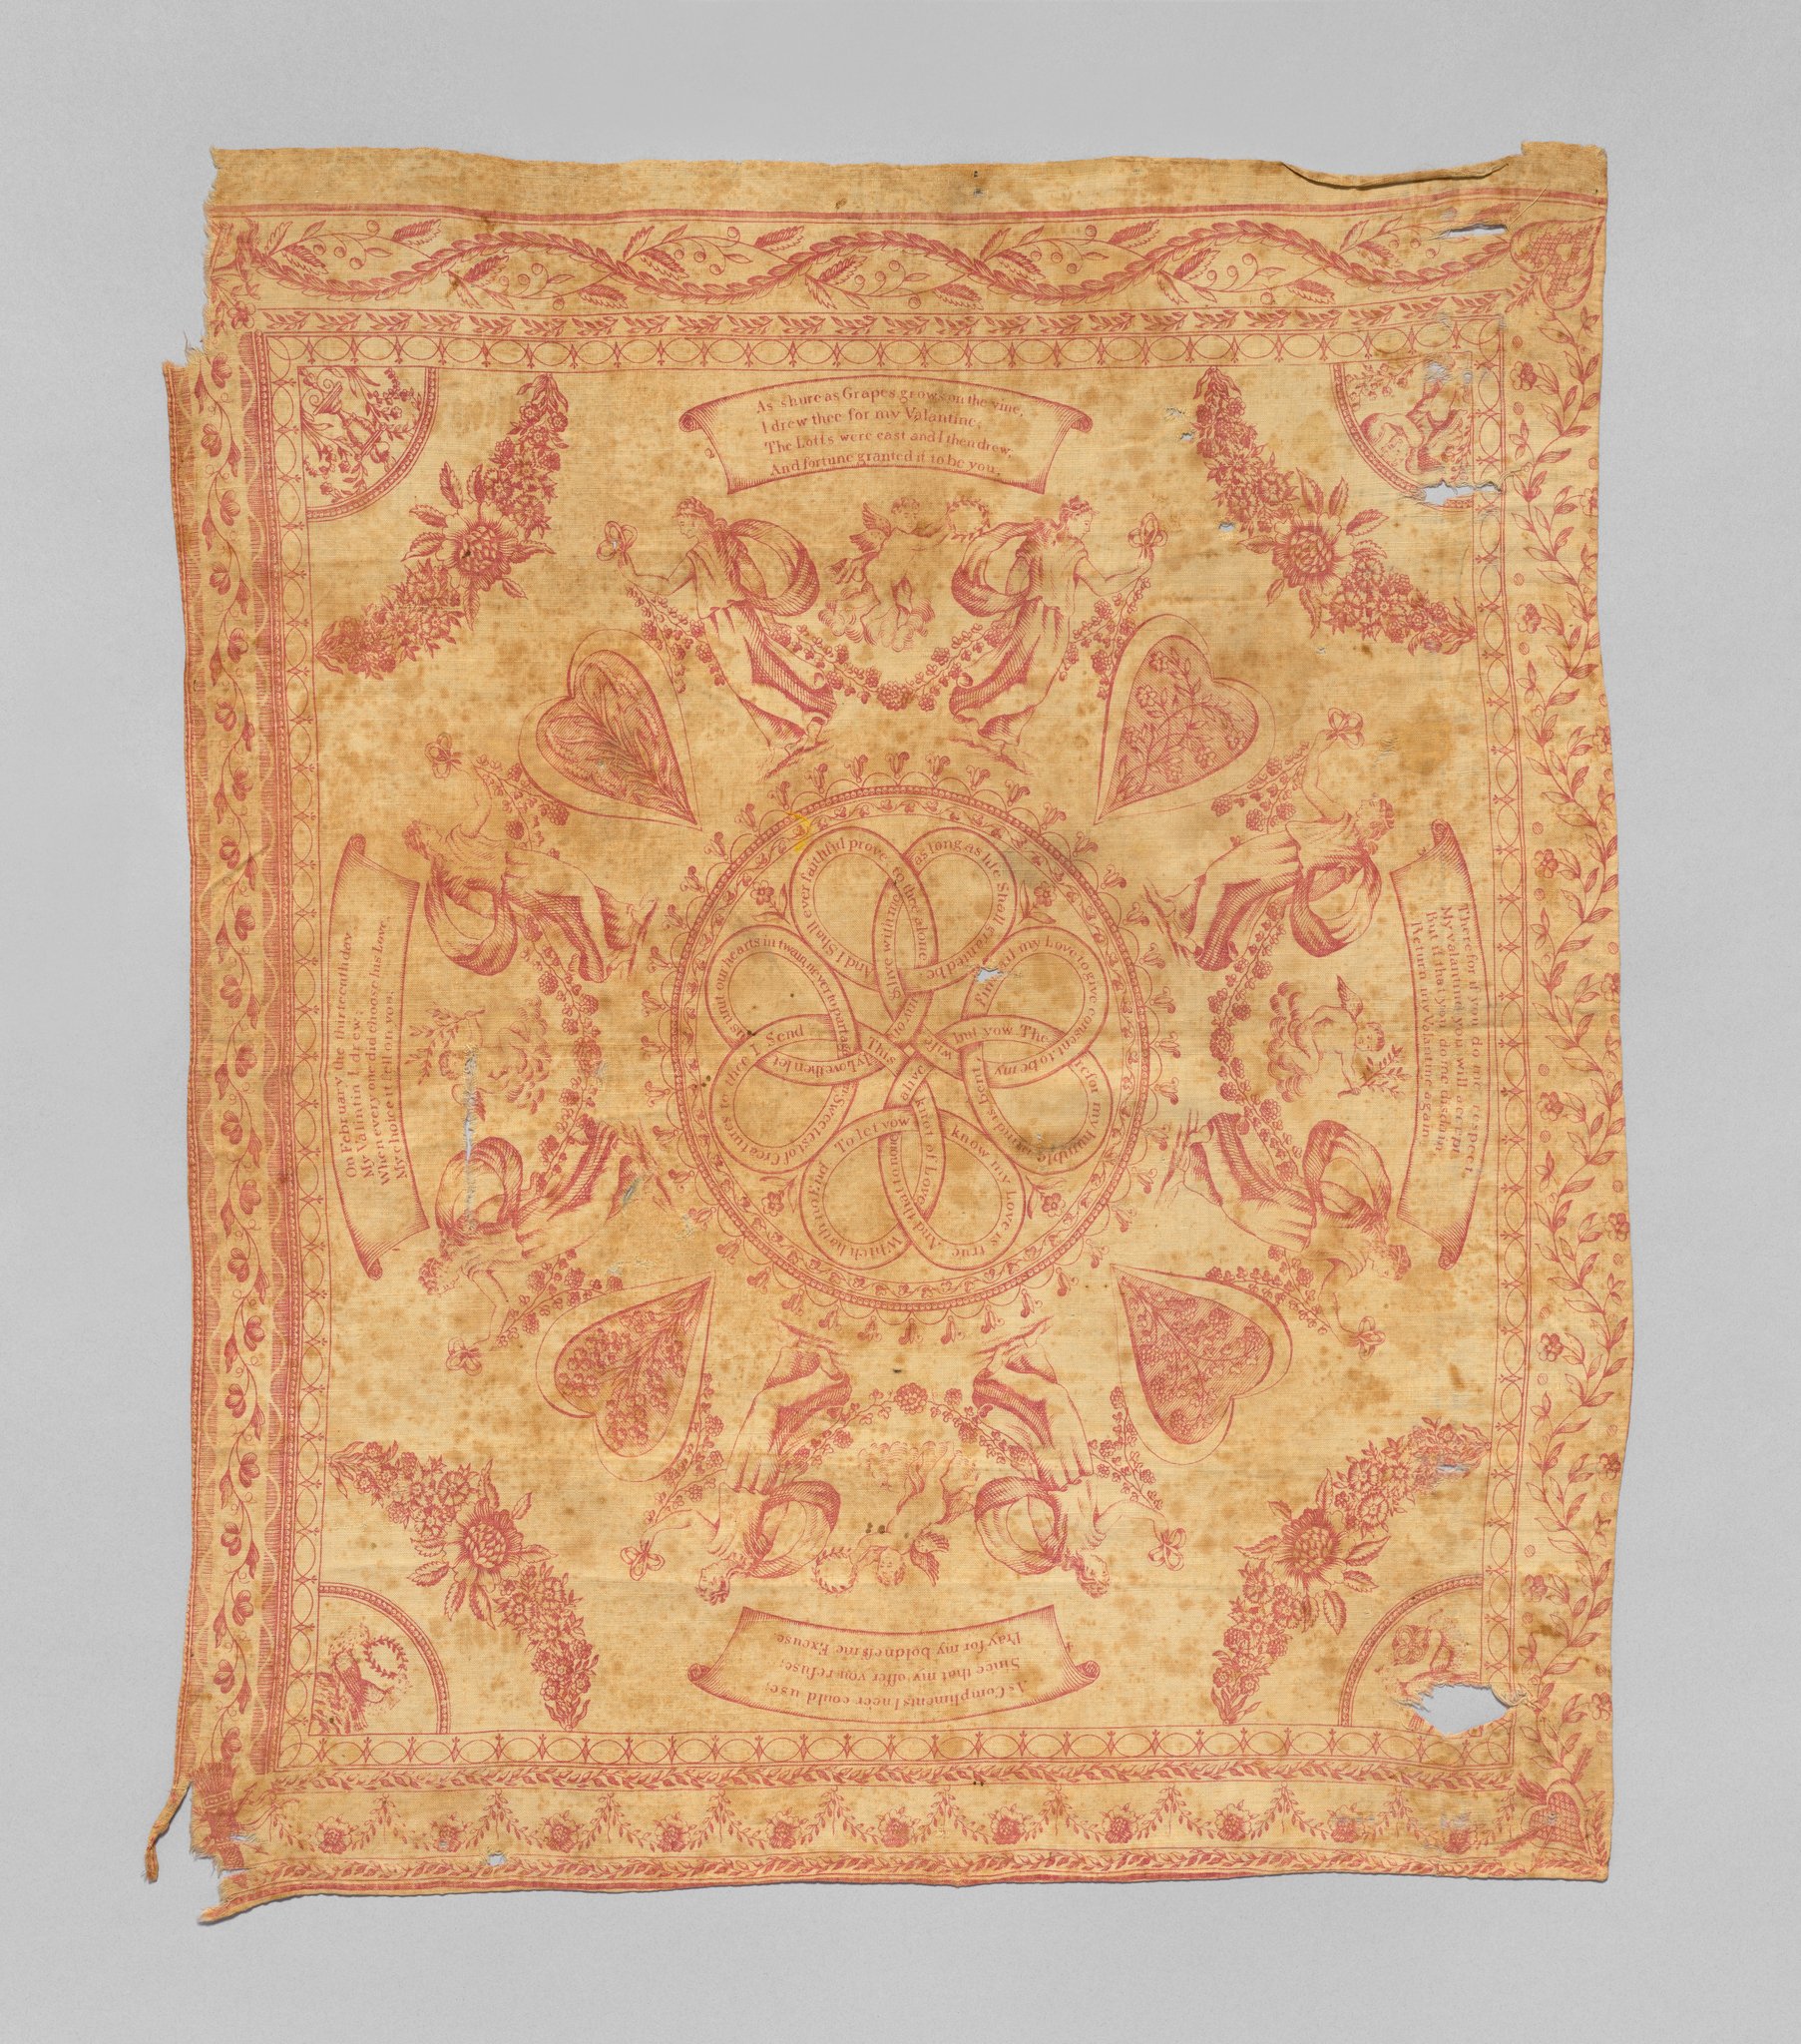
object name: handkerchief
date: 1801-1833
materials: cotton